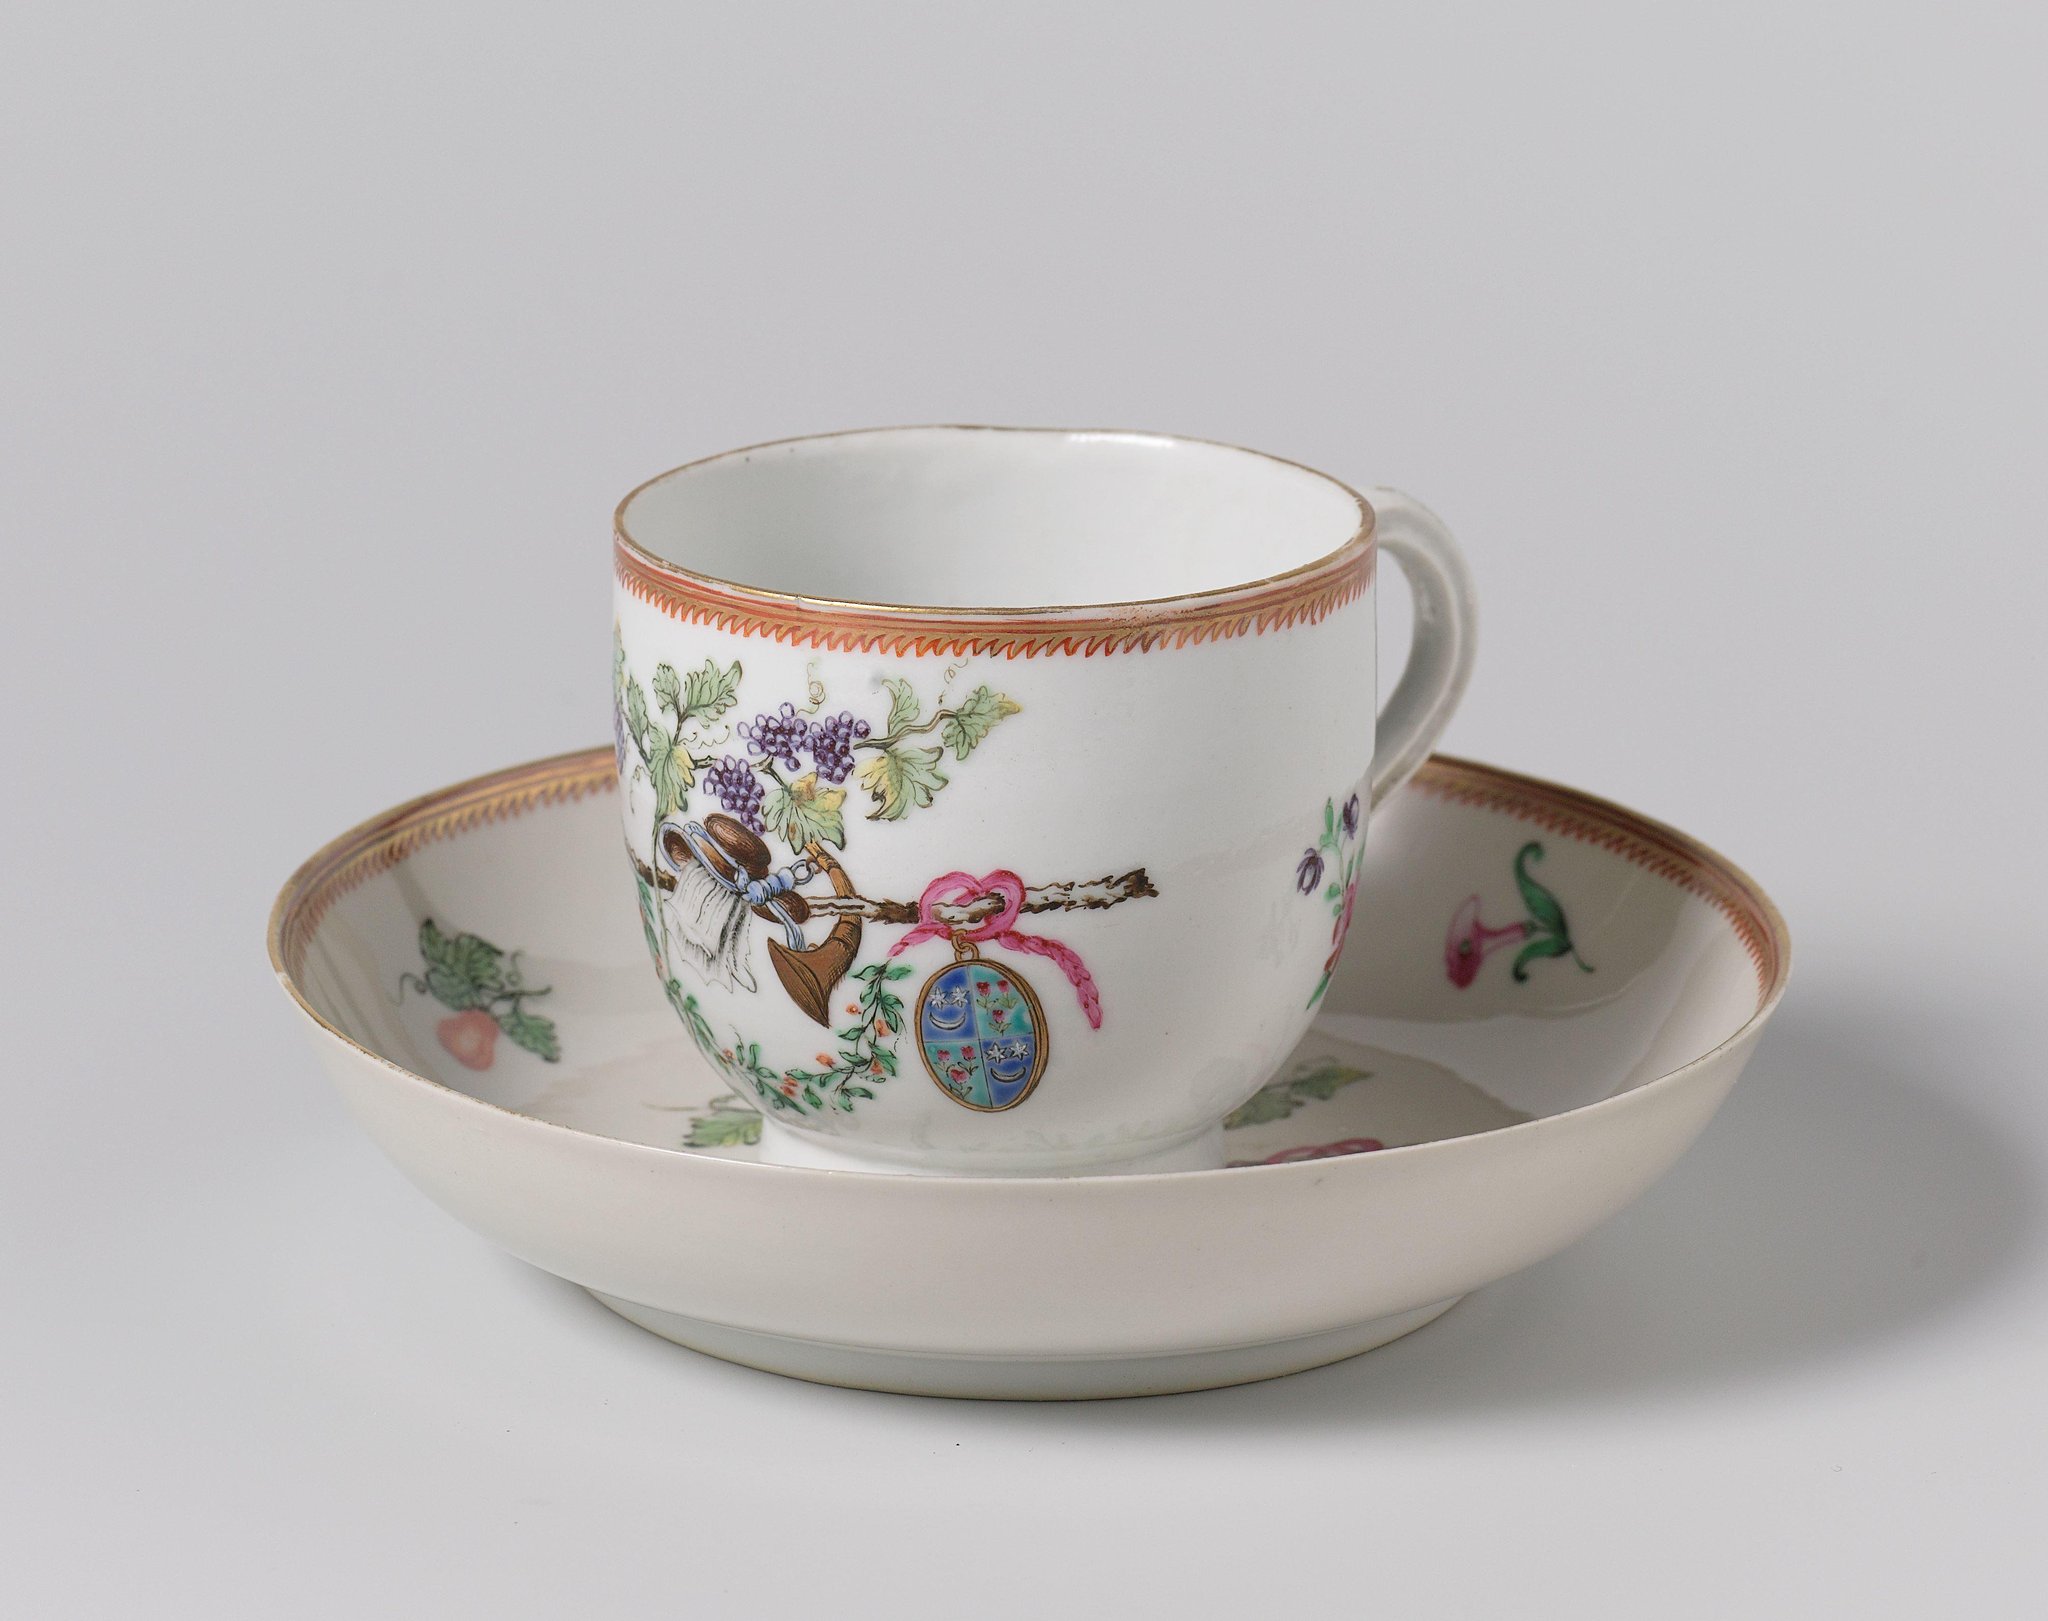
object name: cup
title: Cup with handle with the arms of the Visvliet and Sluymer families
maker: Anonymous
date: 1777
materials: glaze, gold, paint, porcelain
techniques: firing, gilding, turning, vitrification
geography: china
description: Kop en schotel van porselein. Versierd met bloem- en vruchtentakken en een stok waaraan een hoed, een blad papier een hoorn en 2 wapenschilden zijn bevestigd. De wapens zijn van de families Visvliet en Sluymer (uit Zeeland).